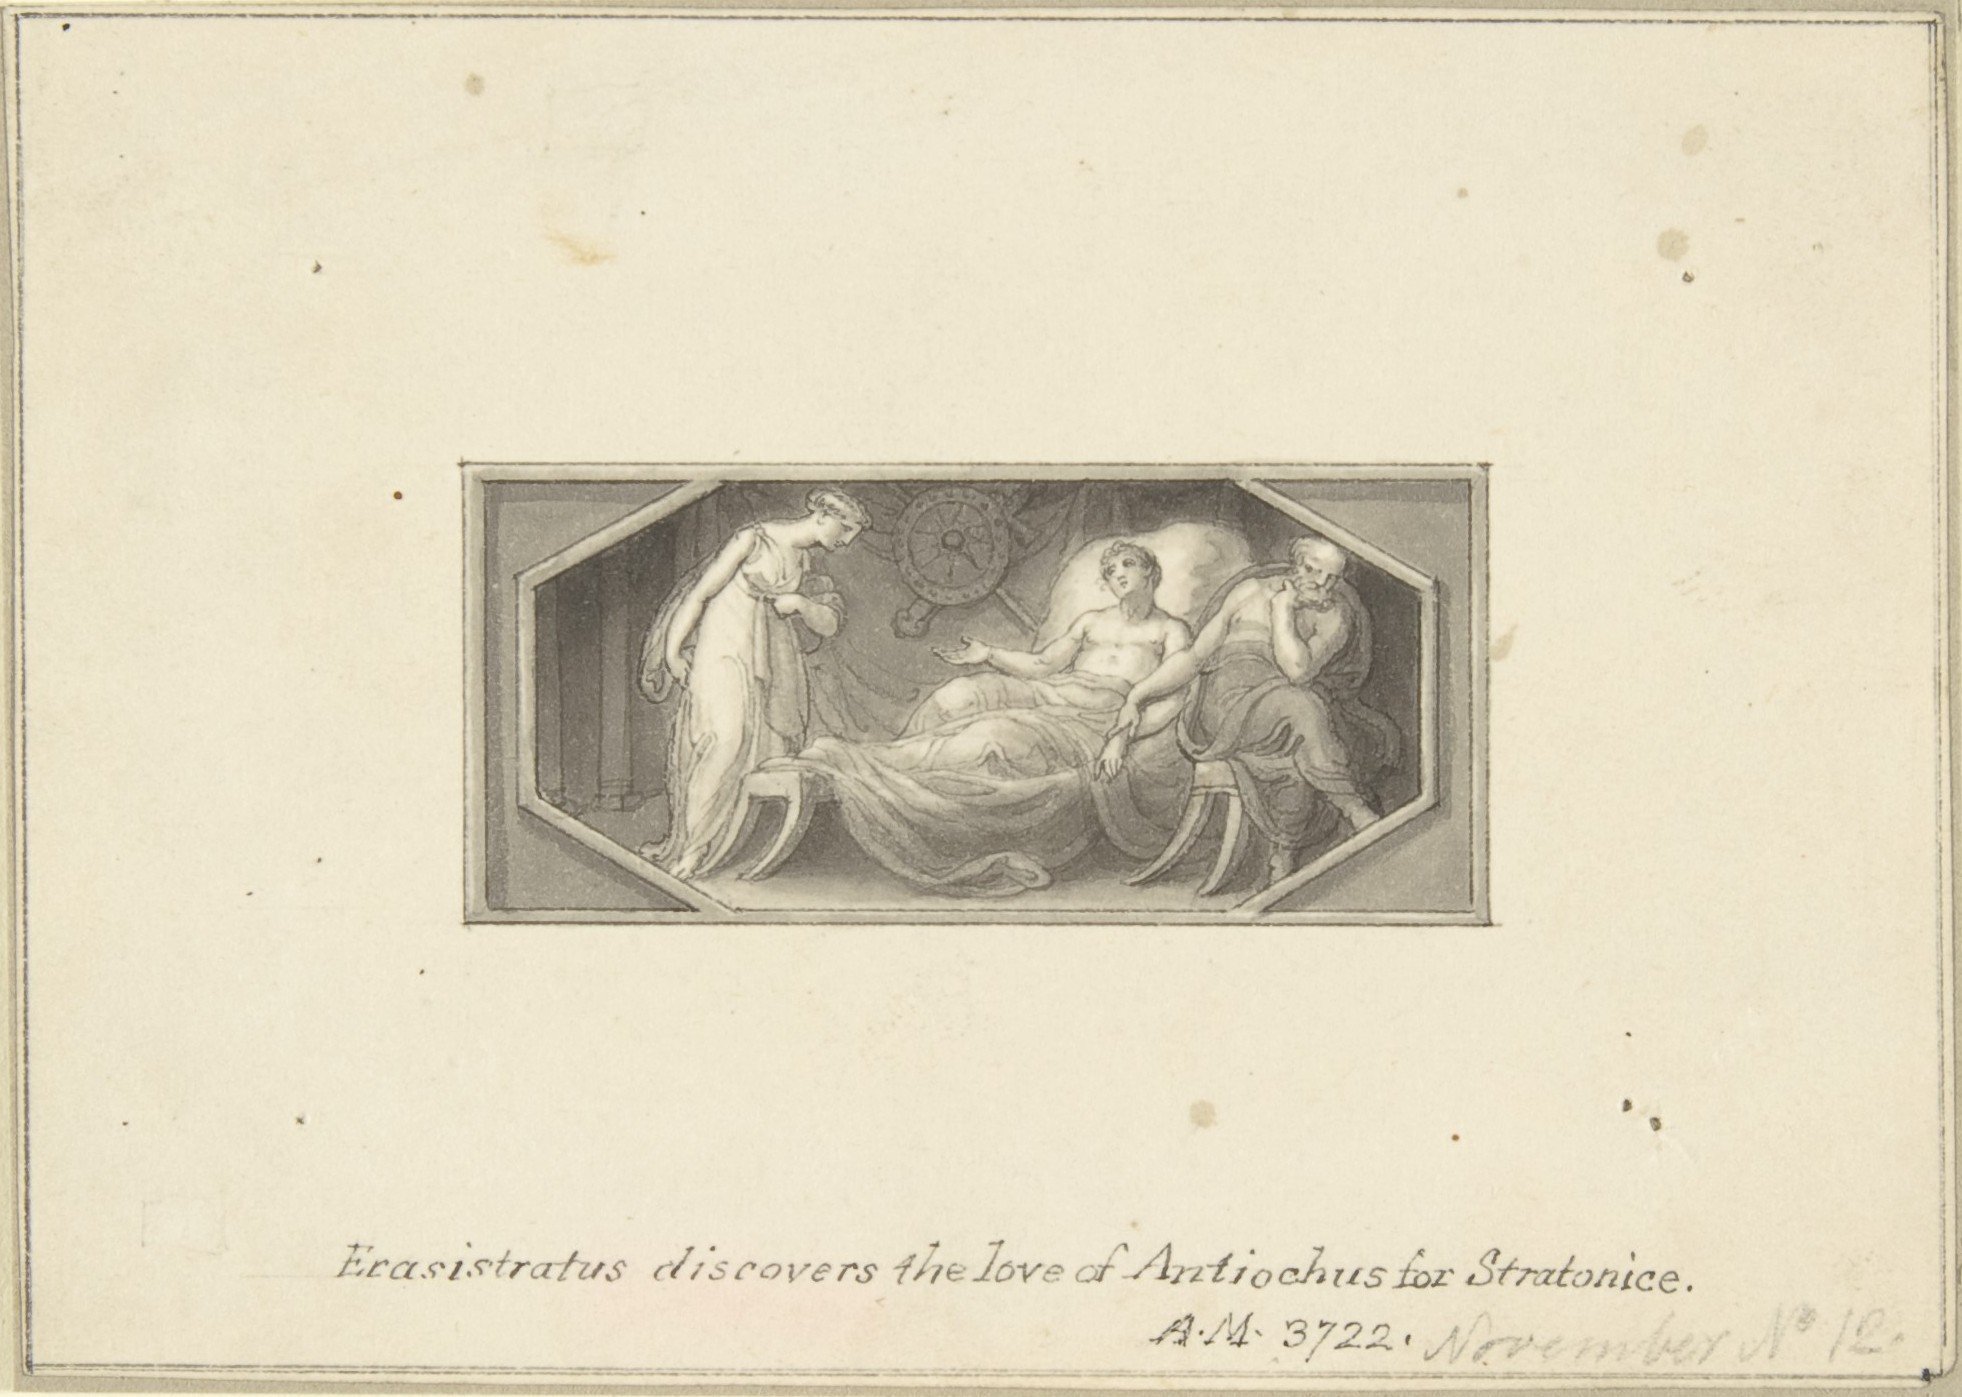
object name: drawing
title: Erasistratus discovers the love of Antiochus for Stratonice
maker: edward francis burney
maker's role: artist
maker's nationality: british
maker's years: 1760-1848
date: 1790-1800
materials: ink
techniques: brush, pen, wash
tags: men,women